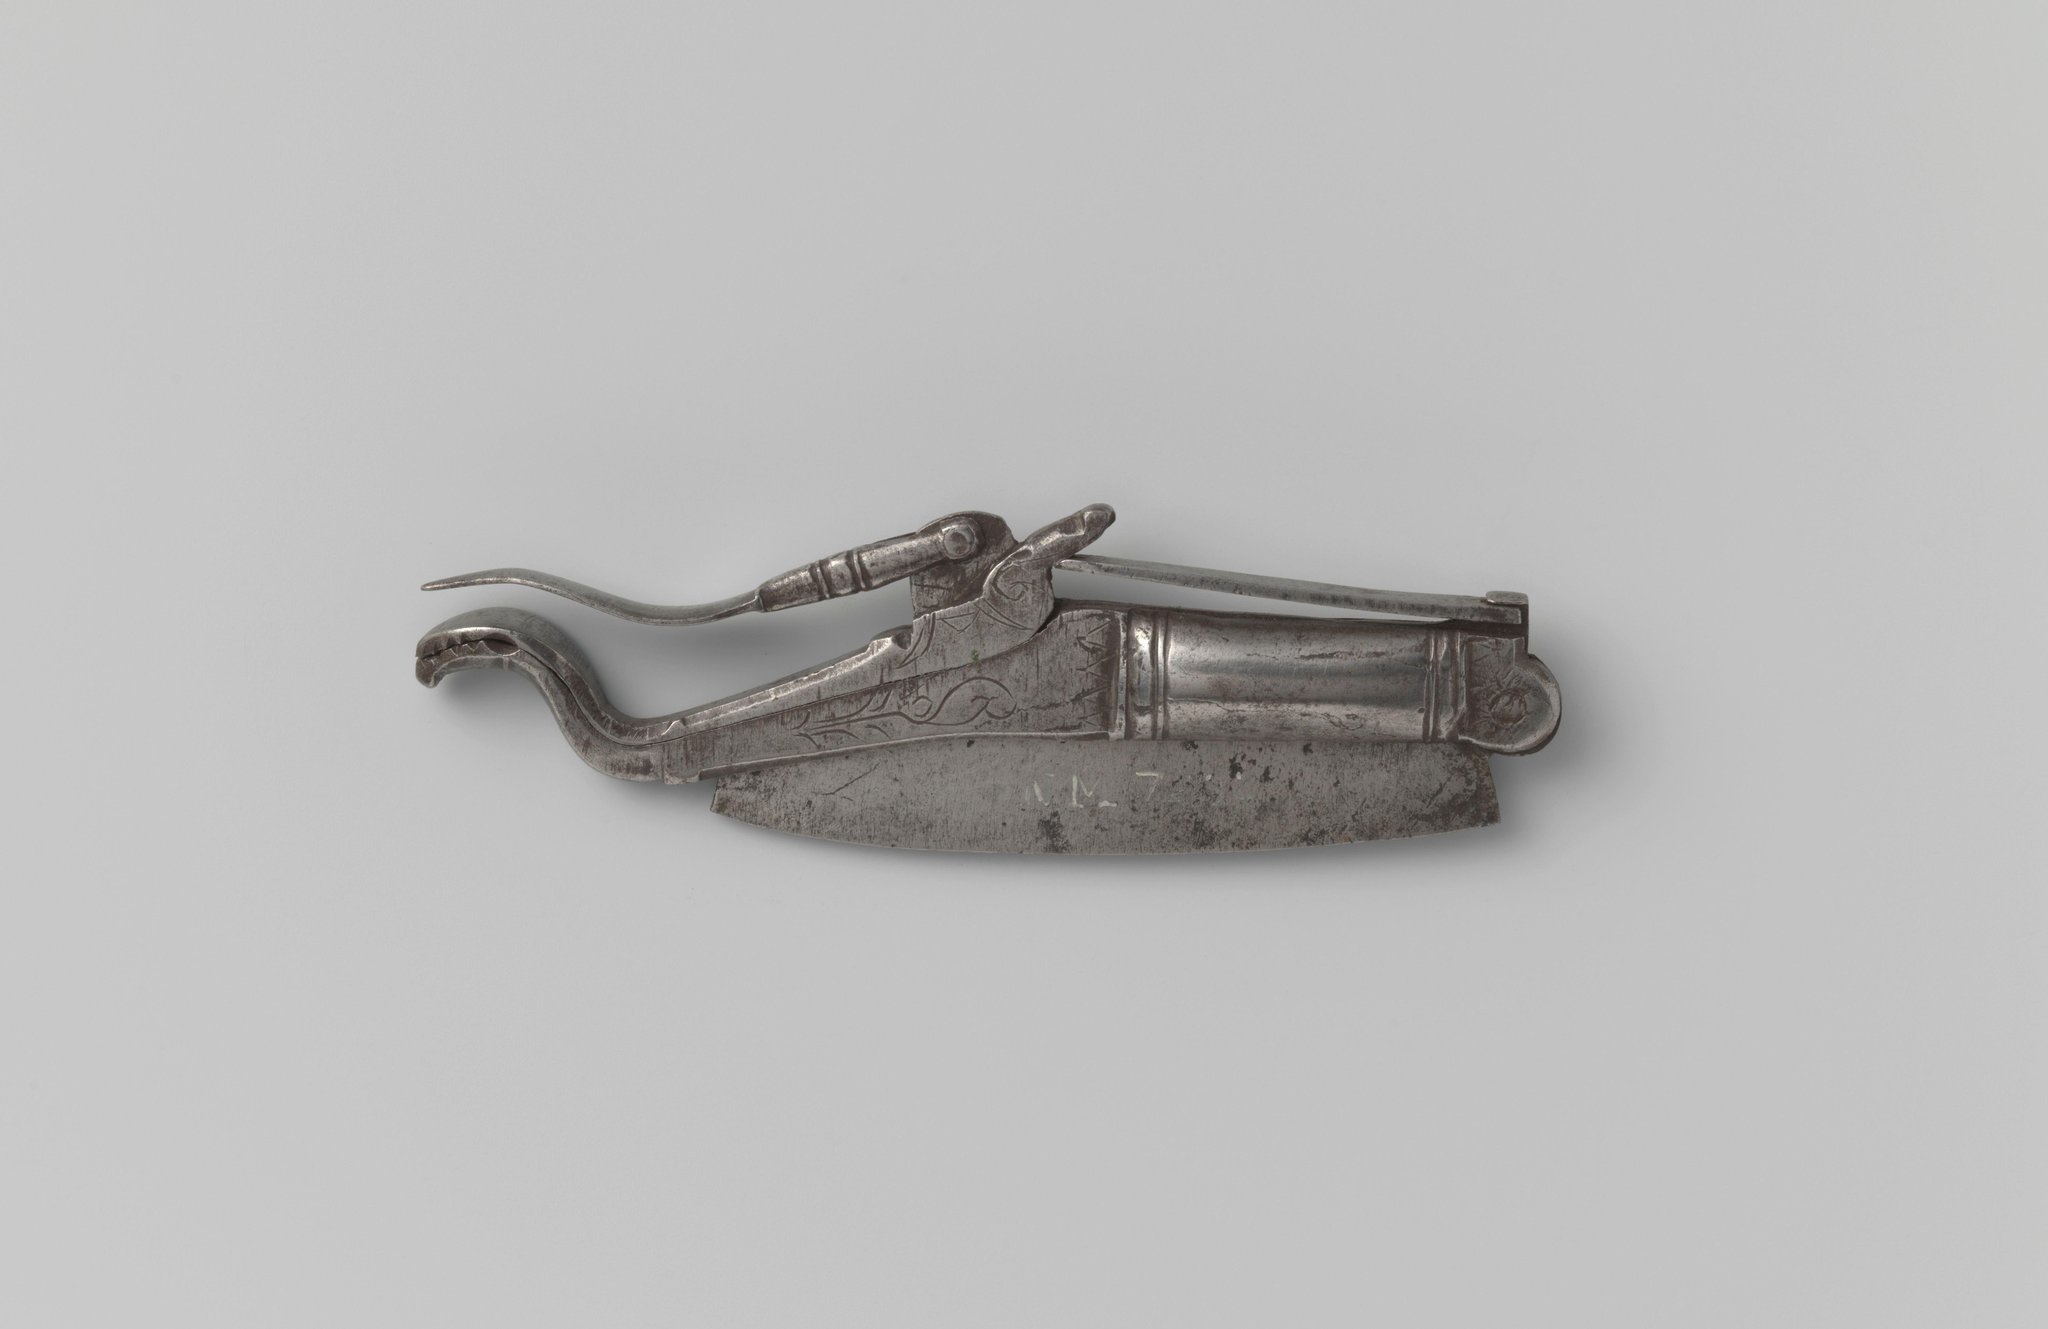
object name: jackknife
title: Knipmes van ijzer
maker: Anonymous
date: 1600-1699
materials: iron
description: Een geheel ijzeren knipmes. De punt ontbreekt. (Door rokers gebruikt).